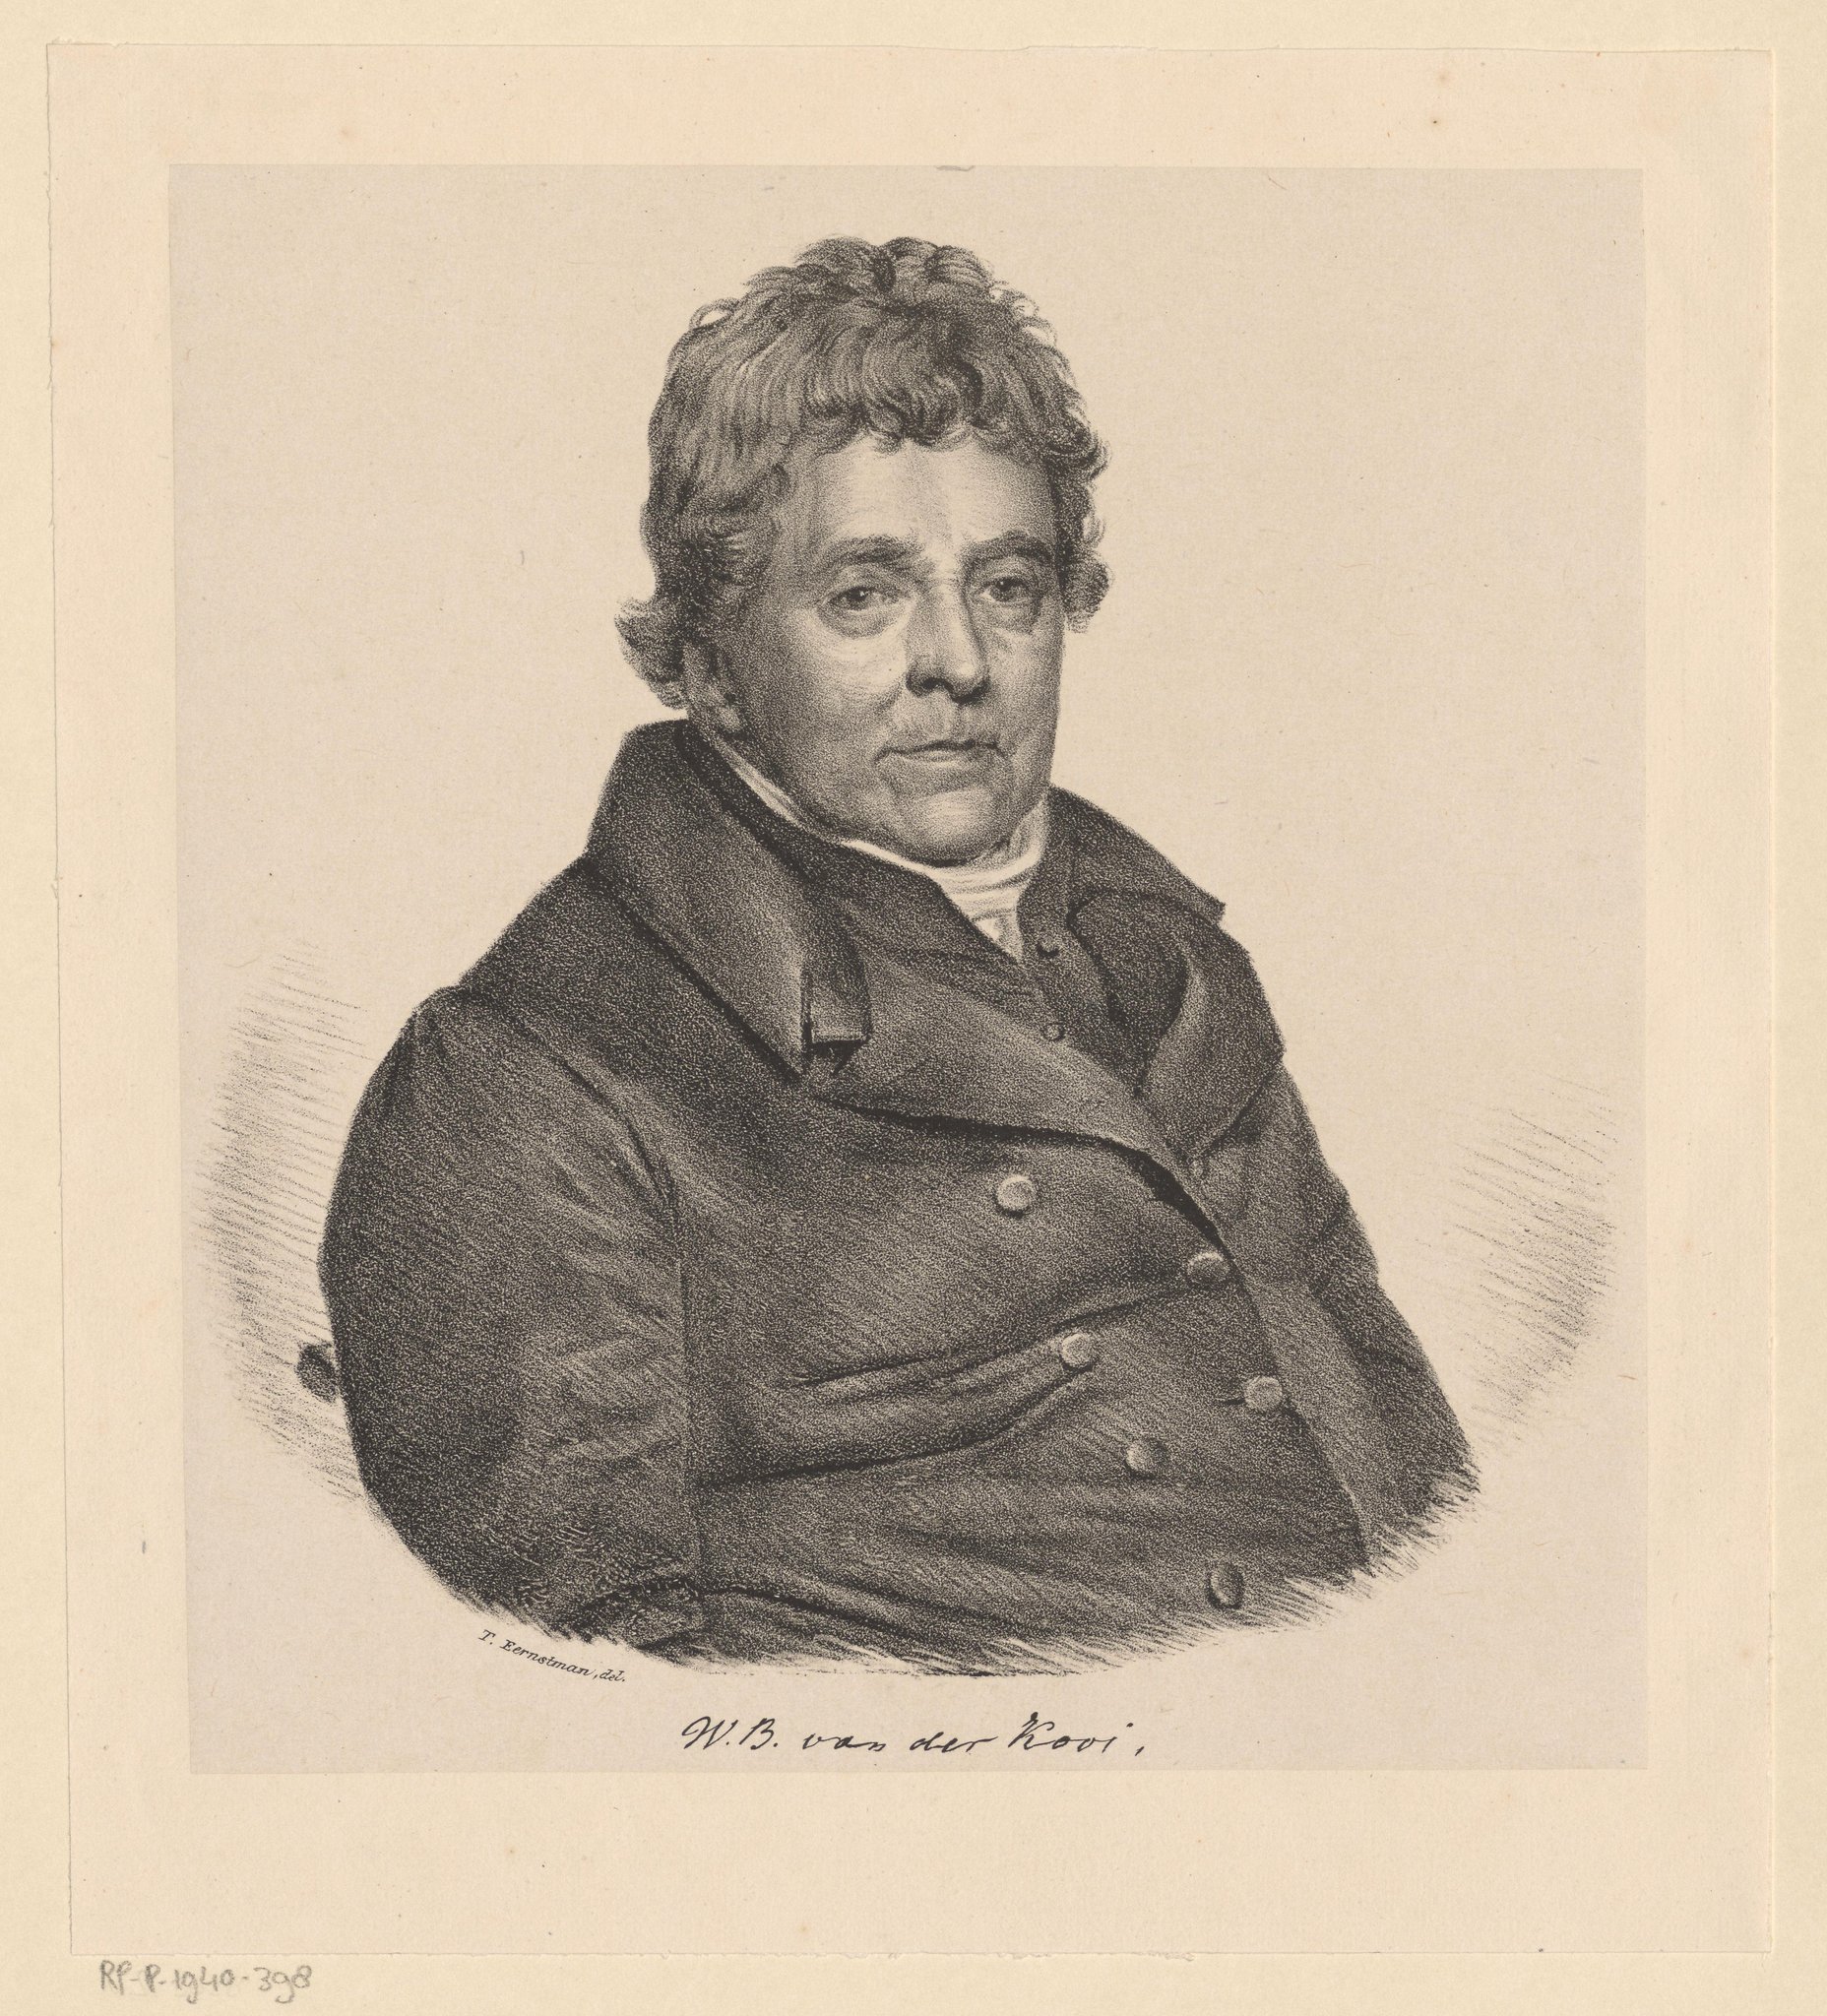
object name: print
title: Portret van Willem Bartel van der Kooi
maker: tjeerd eernstman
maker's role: draughtsman, print maker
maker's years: 1801-1886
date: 1811-1886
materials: paper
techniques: lithograph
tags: painter, print maker, draughtsman, willem bartel van der kooi, historical persons, portrait, self-portrait of painter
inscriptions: collector's mark: Lugt 2228, collector's mark: Lugt 2760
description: Onder het portret een facsimile van de handtekening van de geportretteerde.